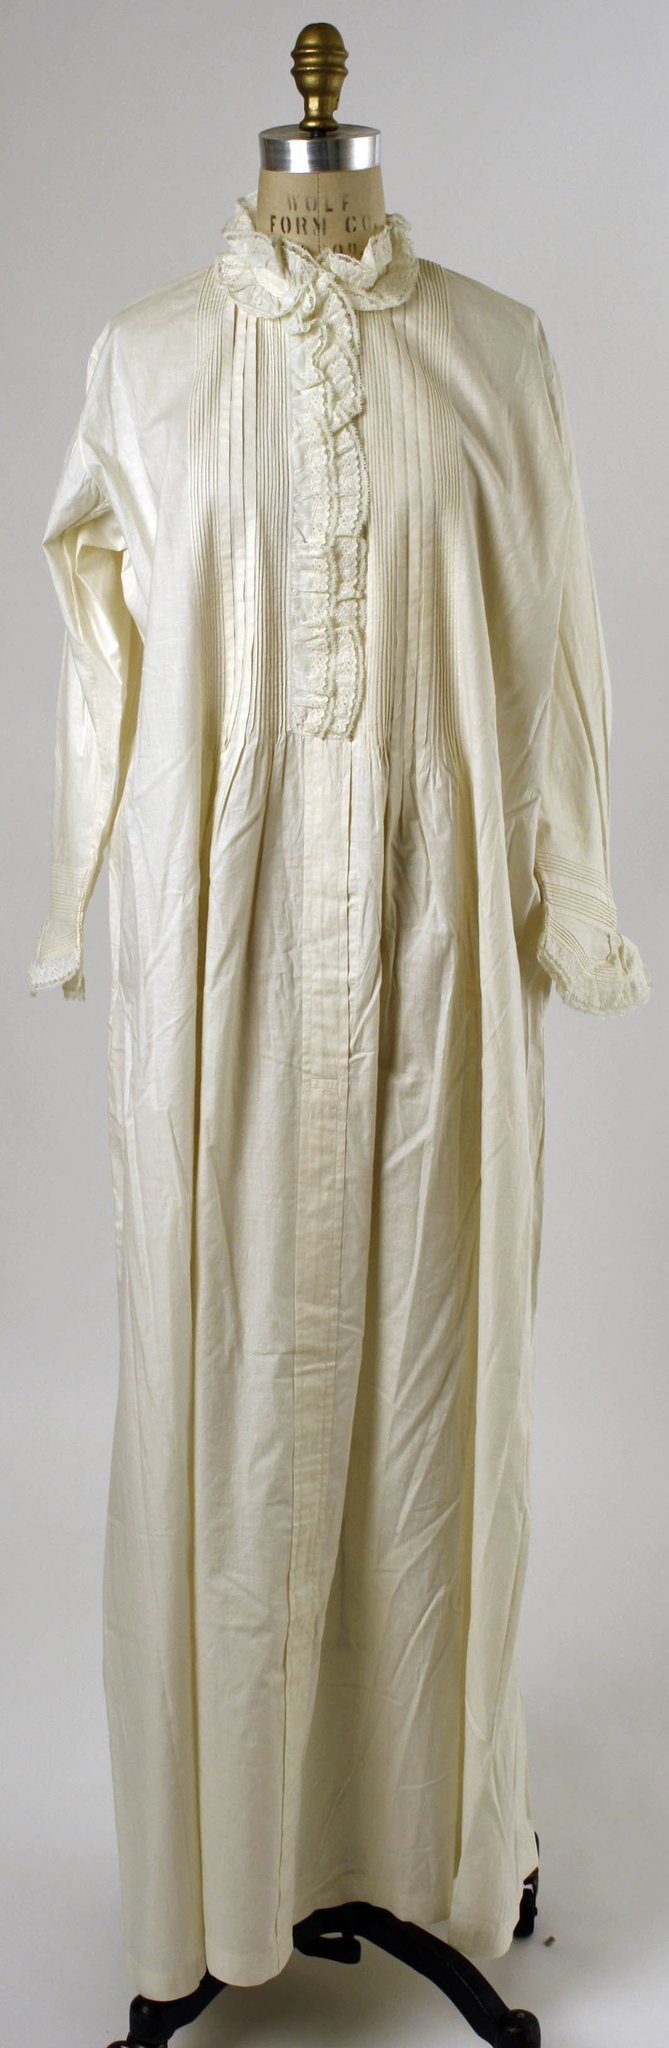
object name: nightgown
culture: american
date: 1880-1889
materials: cotton